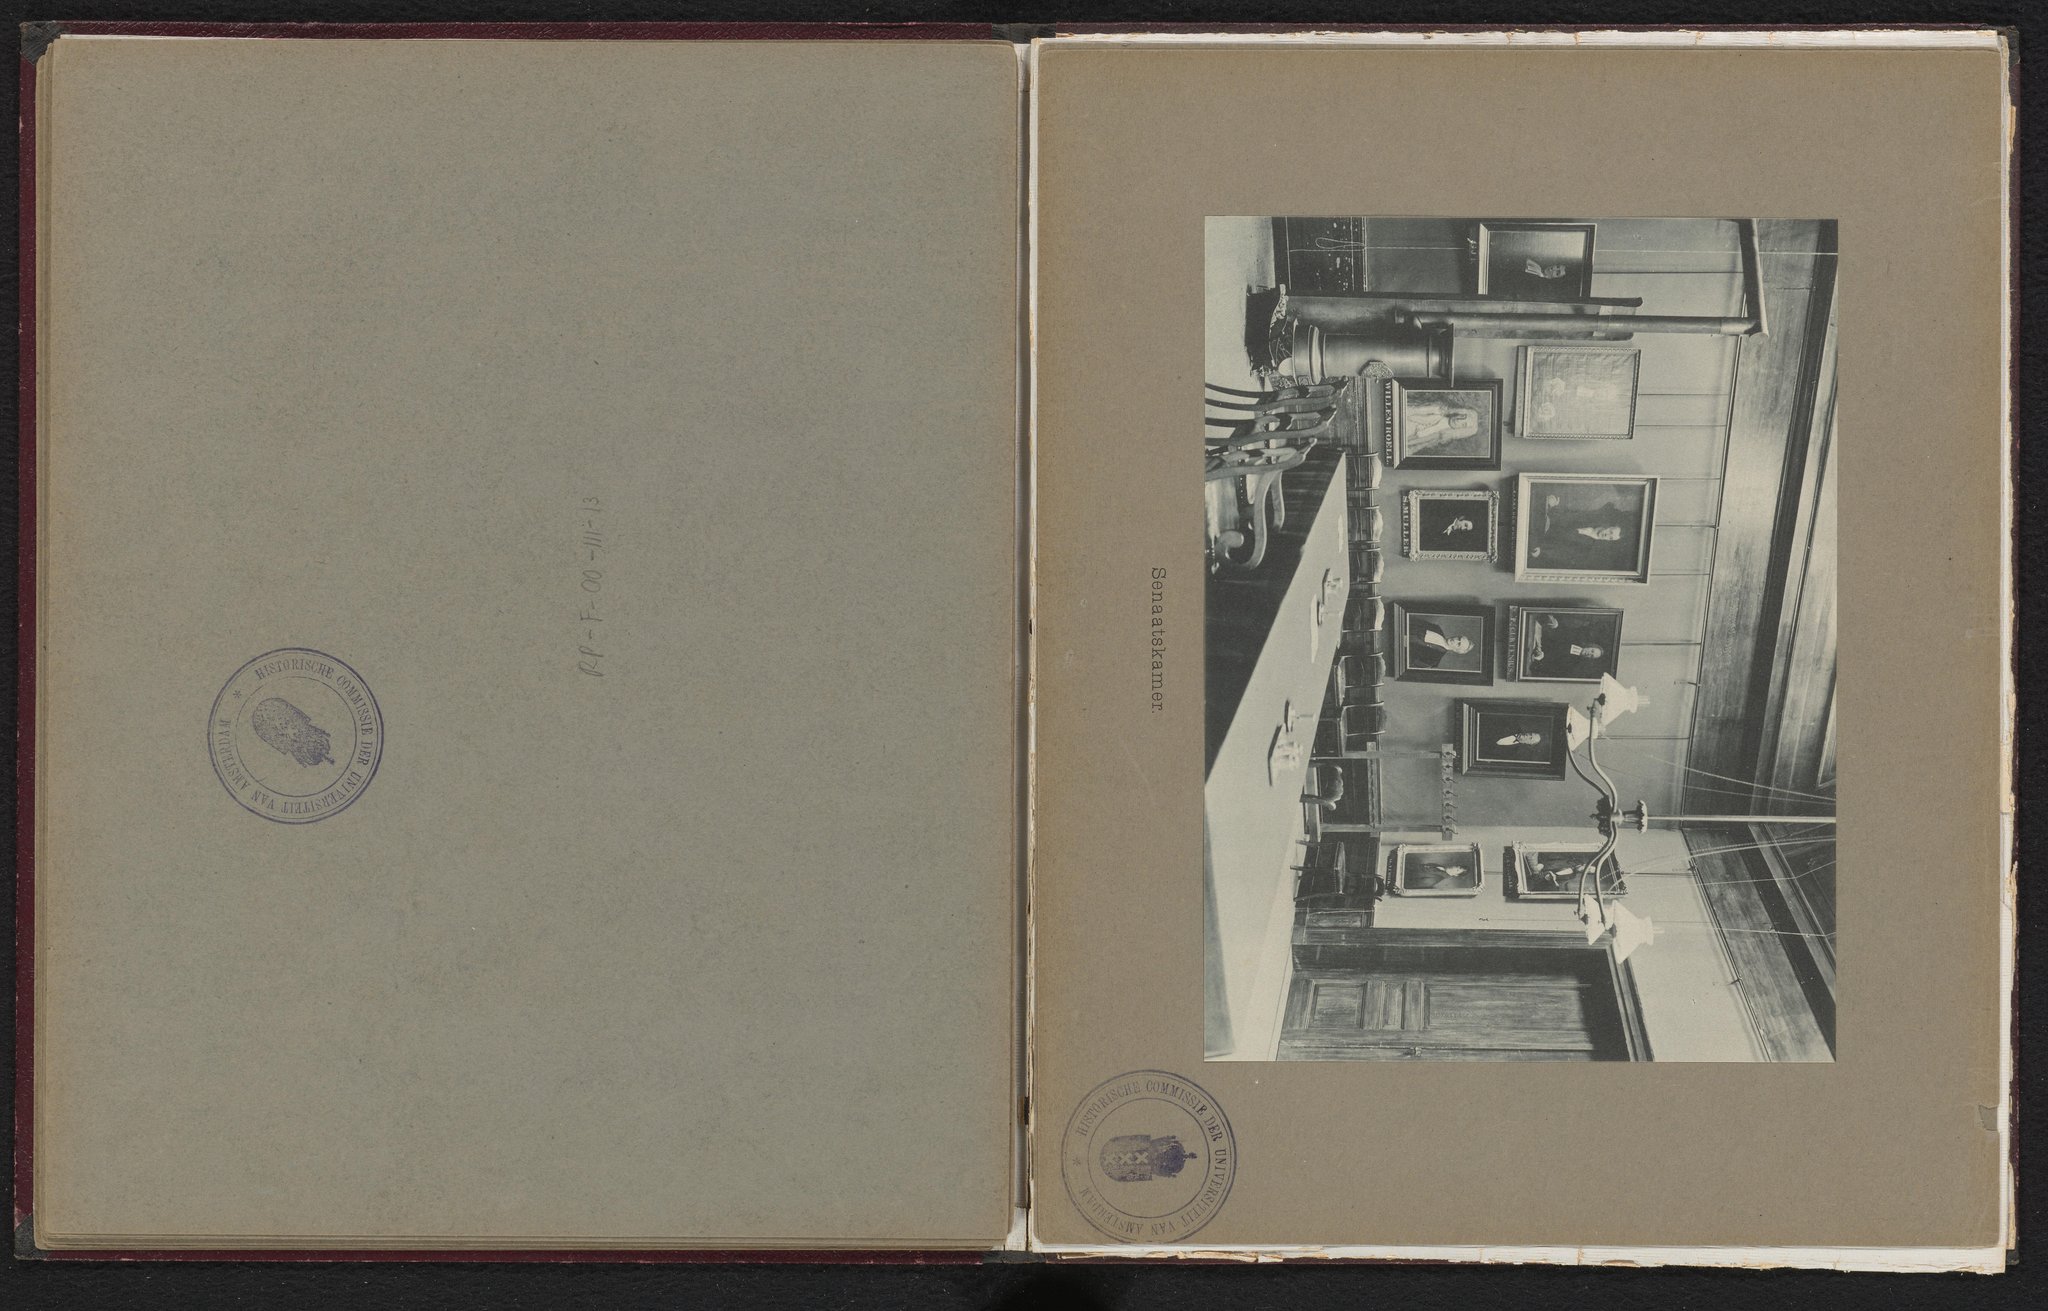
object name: photomechanical print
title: Senaatskamer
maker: Anonymous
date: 1902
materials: cardboard, paper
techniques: photograph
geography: amsterdam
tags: university building, college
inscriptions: stamp: ‘HISTORISCHE COMMISSIE DER UNIVERSITEIT VAN AMSTERDAM’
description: Deze prent maakt deel uit van een omslag met vijftien lichtdrukken op twaalf kartonnen bladen.